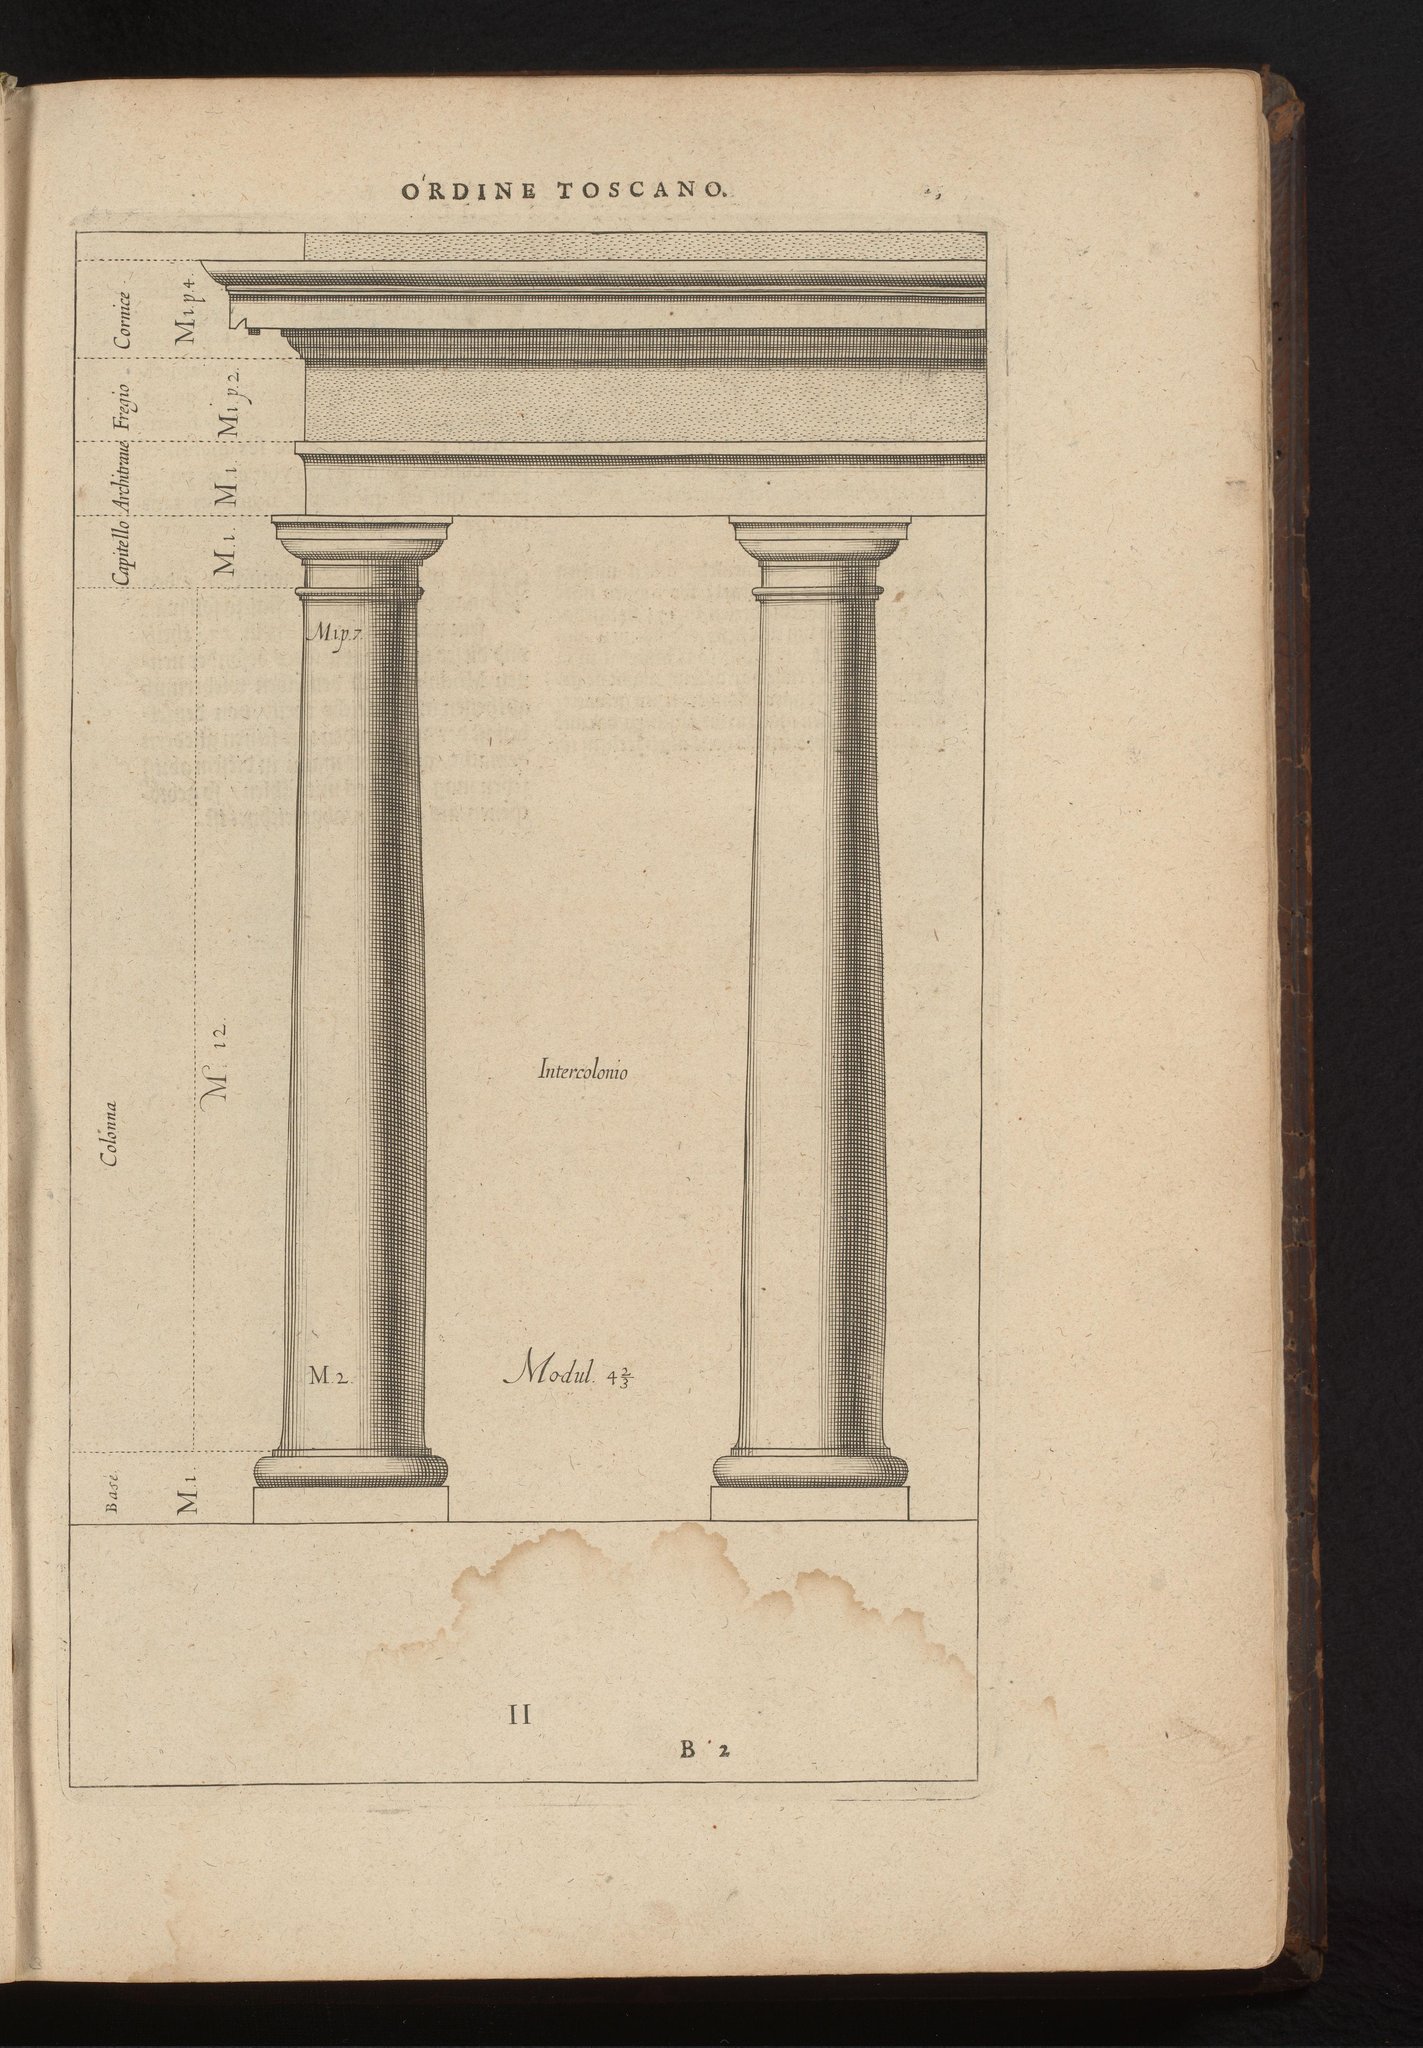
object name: book illustration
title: Toscaanse zuilen en hoofdgestel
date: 1640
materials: paper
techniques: engraving, letterpress printing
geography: amsterdam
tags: tuscan order ~ architecture, orders, order-books ~ architecture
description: Prent uit: Vignola, Giacomo Barozzi da. Regola delli cinque ordini d'architettura (...). Amsterdam: Johannes Willemszoon en Cornelis Blaeu, 1640, p. 15.